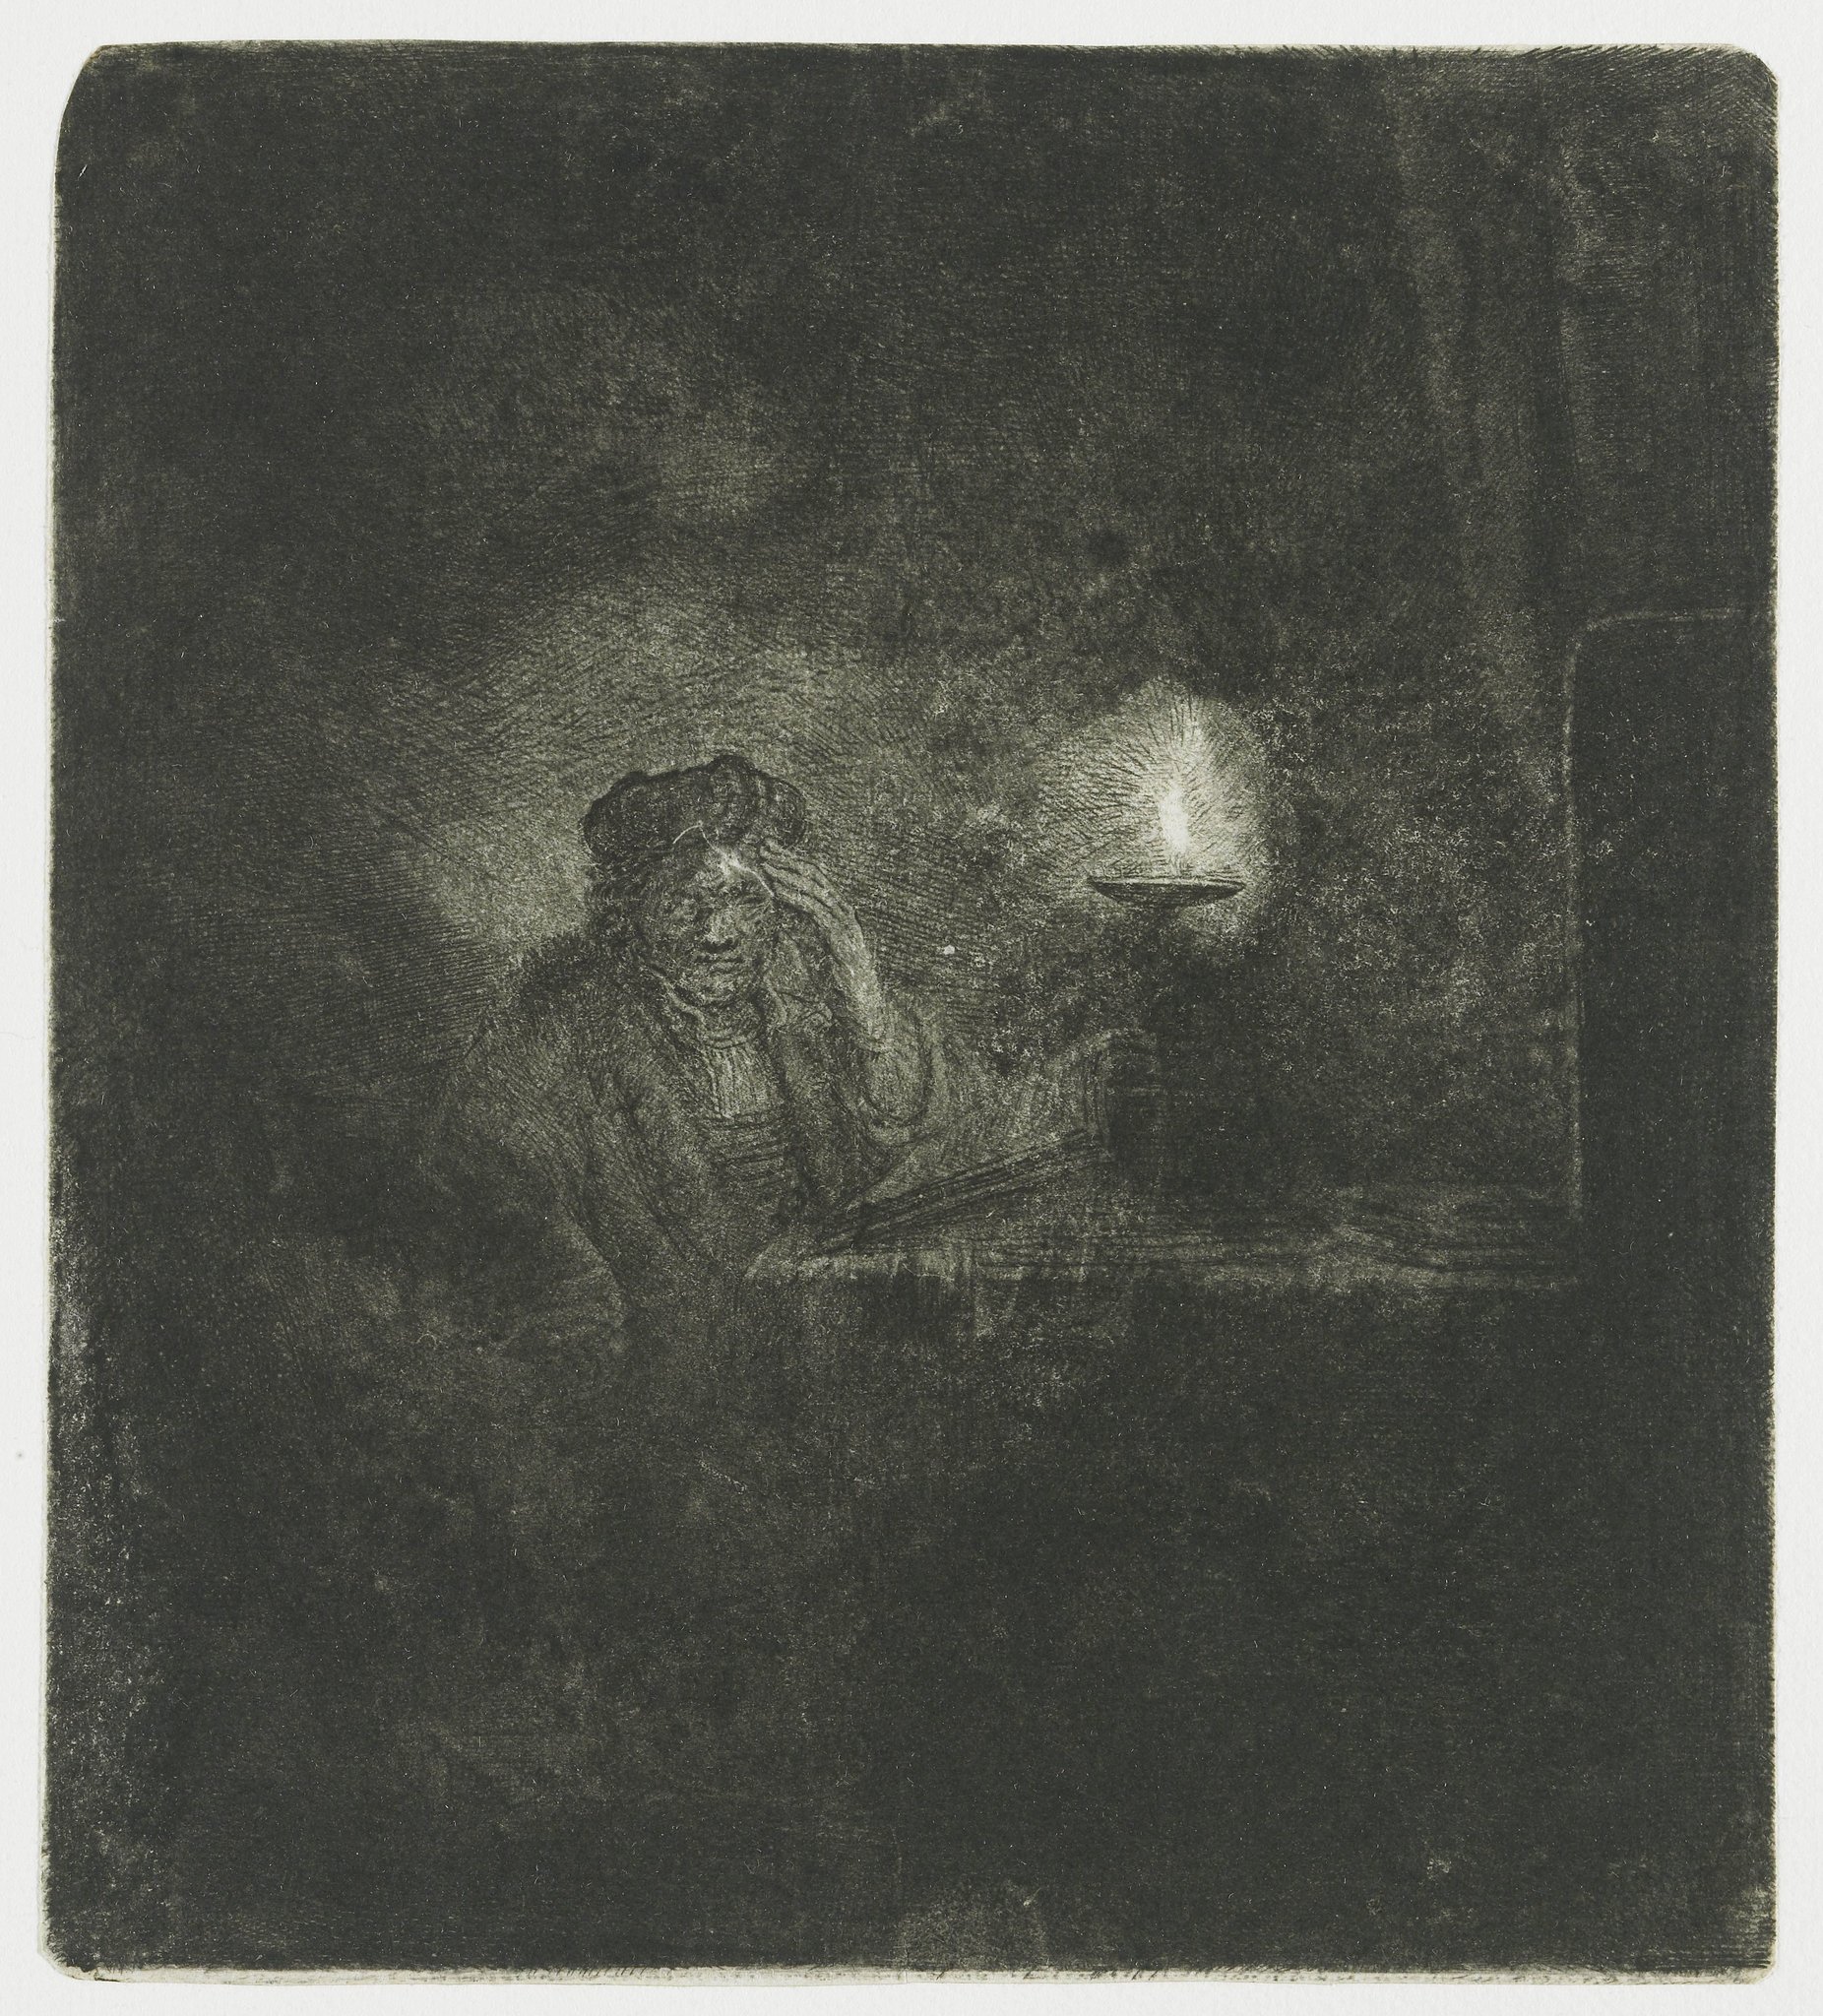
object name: print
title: Student at a table by candlelight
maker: Anonymous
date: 1640-1645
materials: paper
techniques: etching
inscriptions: collector's mark: Lugt 240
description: Kopie naar de gelijknamige prent van Rembrandt.